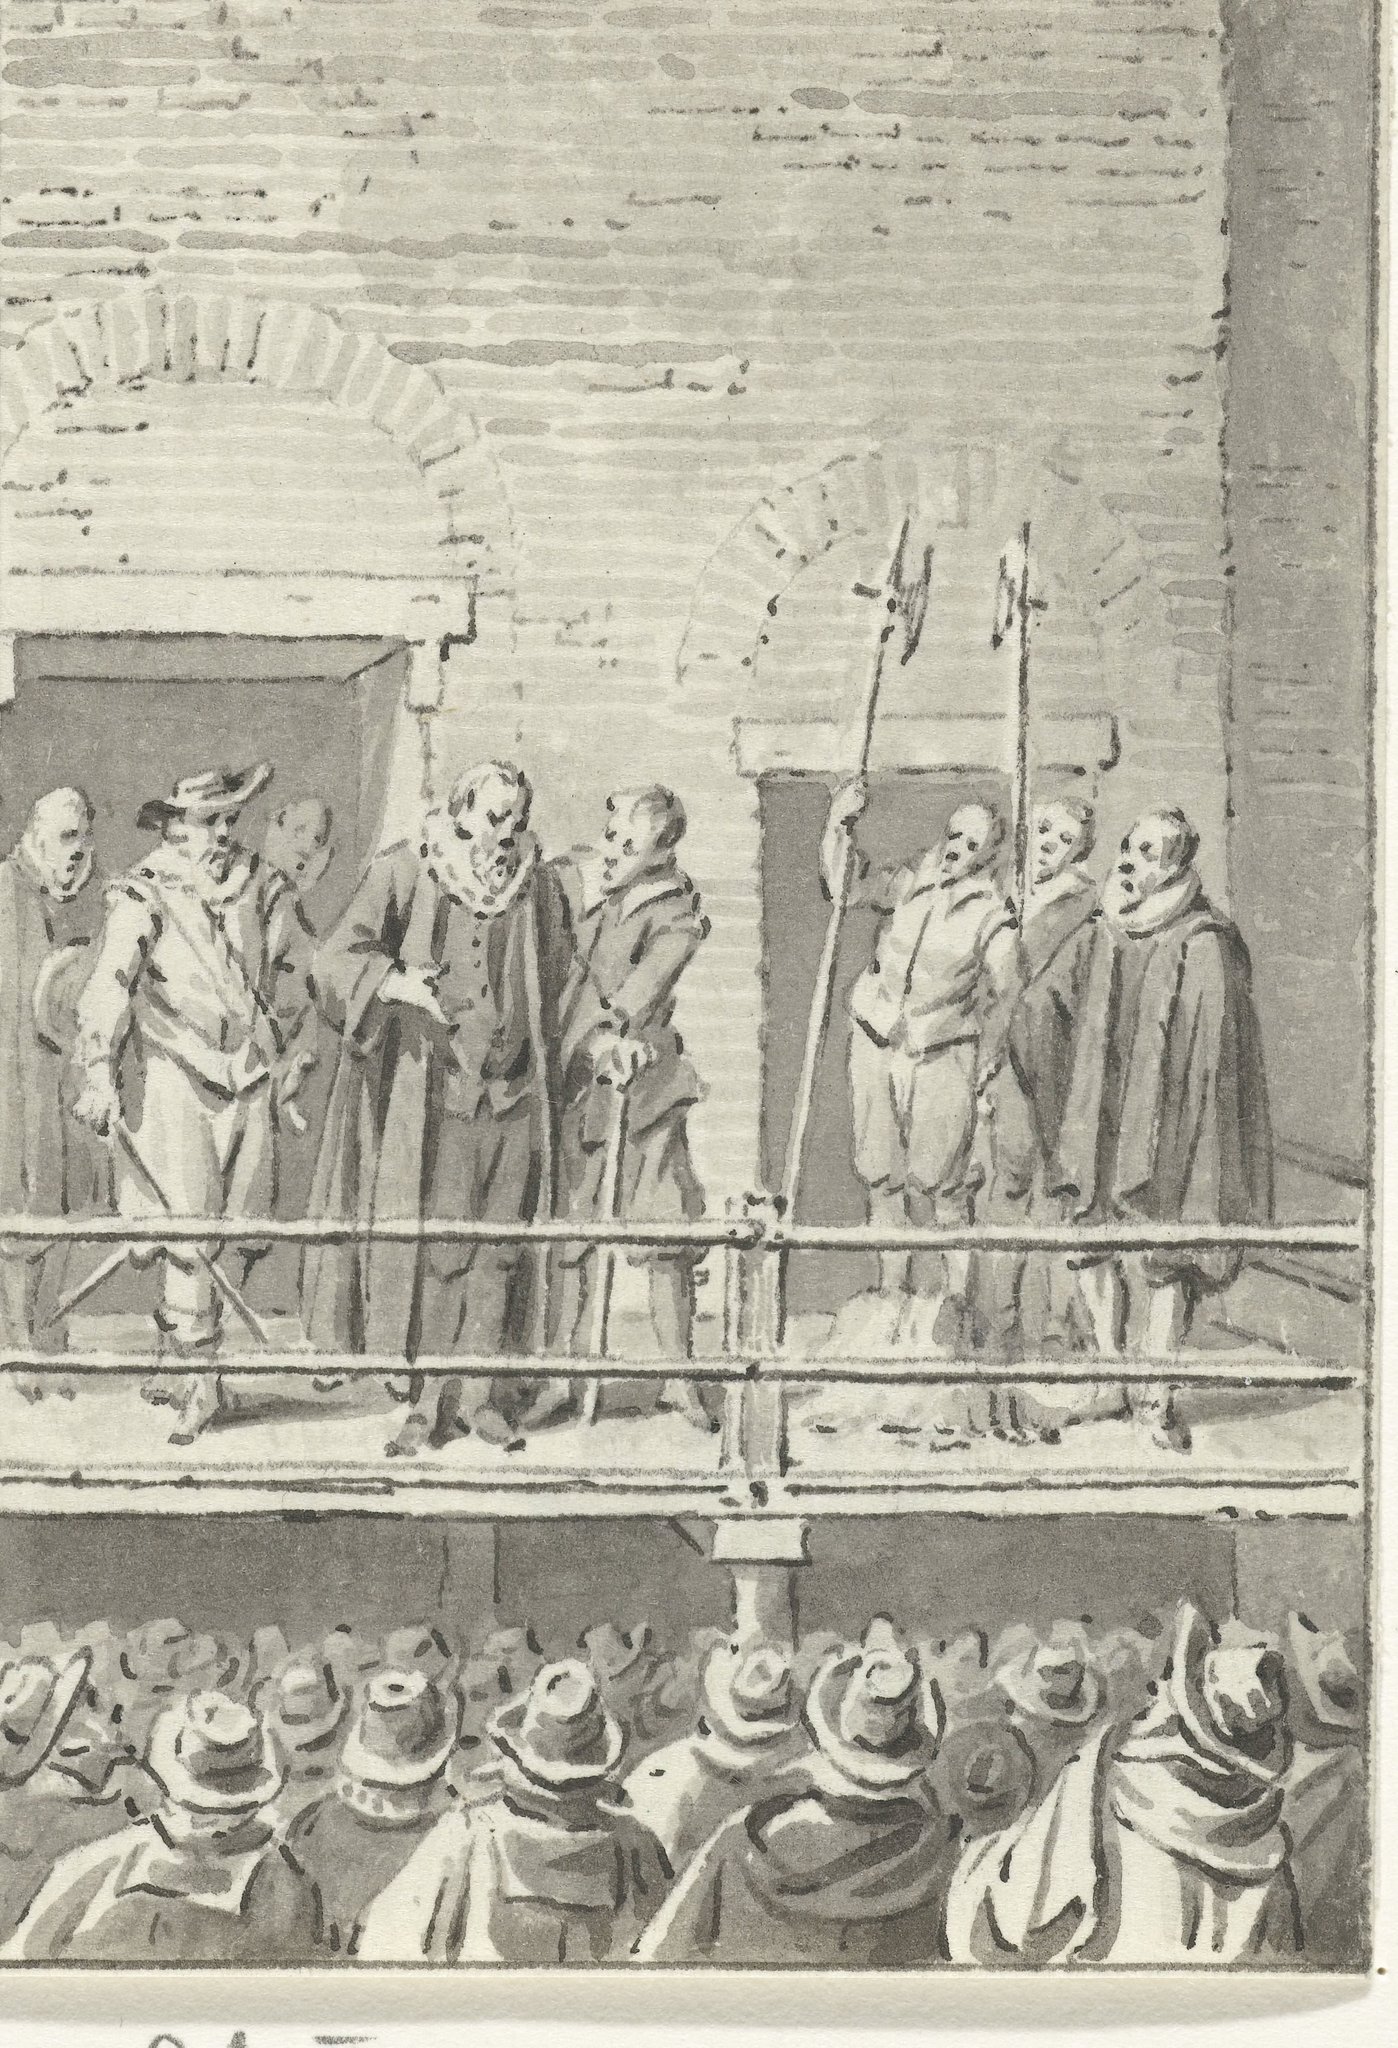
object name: historieplaat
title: Johan van Oldenbarnevelt spreekt vanaf het schavot voor zijn onthoofding de omstanders toe, 13 mei 1619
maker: jacobus buys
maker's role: draughtsman, print maker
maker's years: 1724-1801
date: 1780-1795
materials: ink, paper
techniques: brush, pen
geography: northern netherlands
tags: the hague, johan van oldenbarnevelt, historical persons, on the scaffold or place of execution, historical events and situations, person addressing a group, orator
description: Ontwerptekening voor illustratie in: J. Fokke, Geschiedenissen der Vereenigde Nederlanden voor de vaderlandsche jeugd, Johannes Allart, Amsterdam 1783-1795, 25 delen, dl. VII, pl. II.